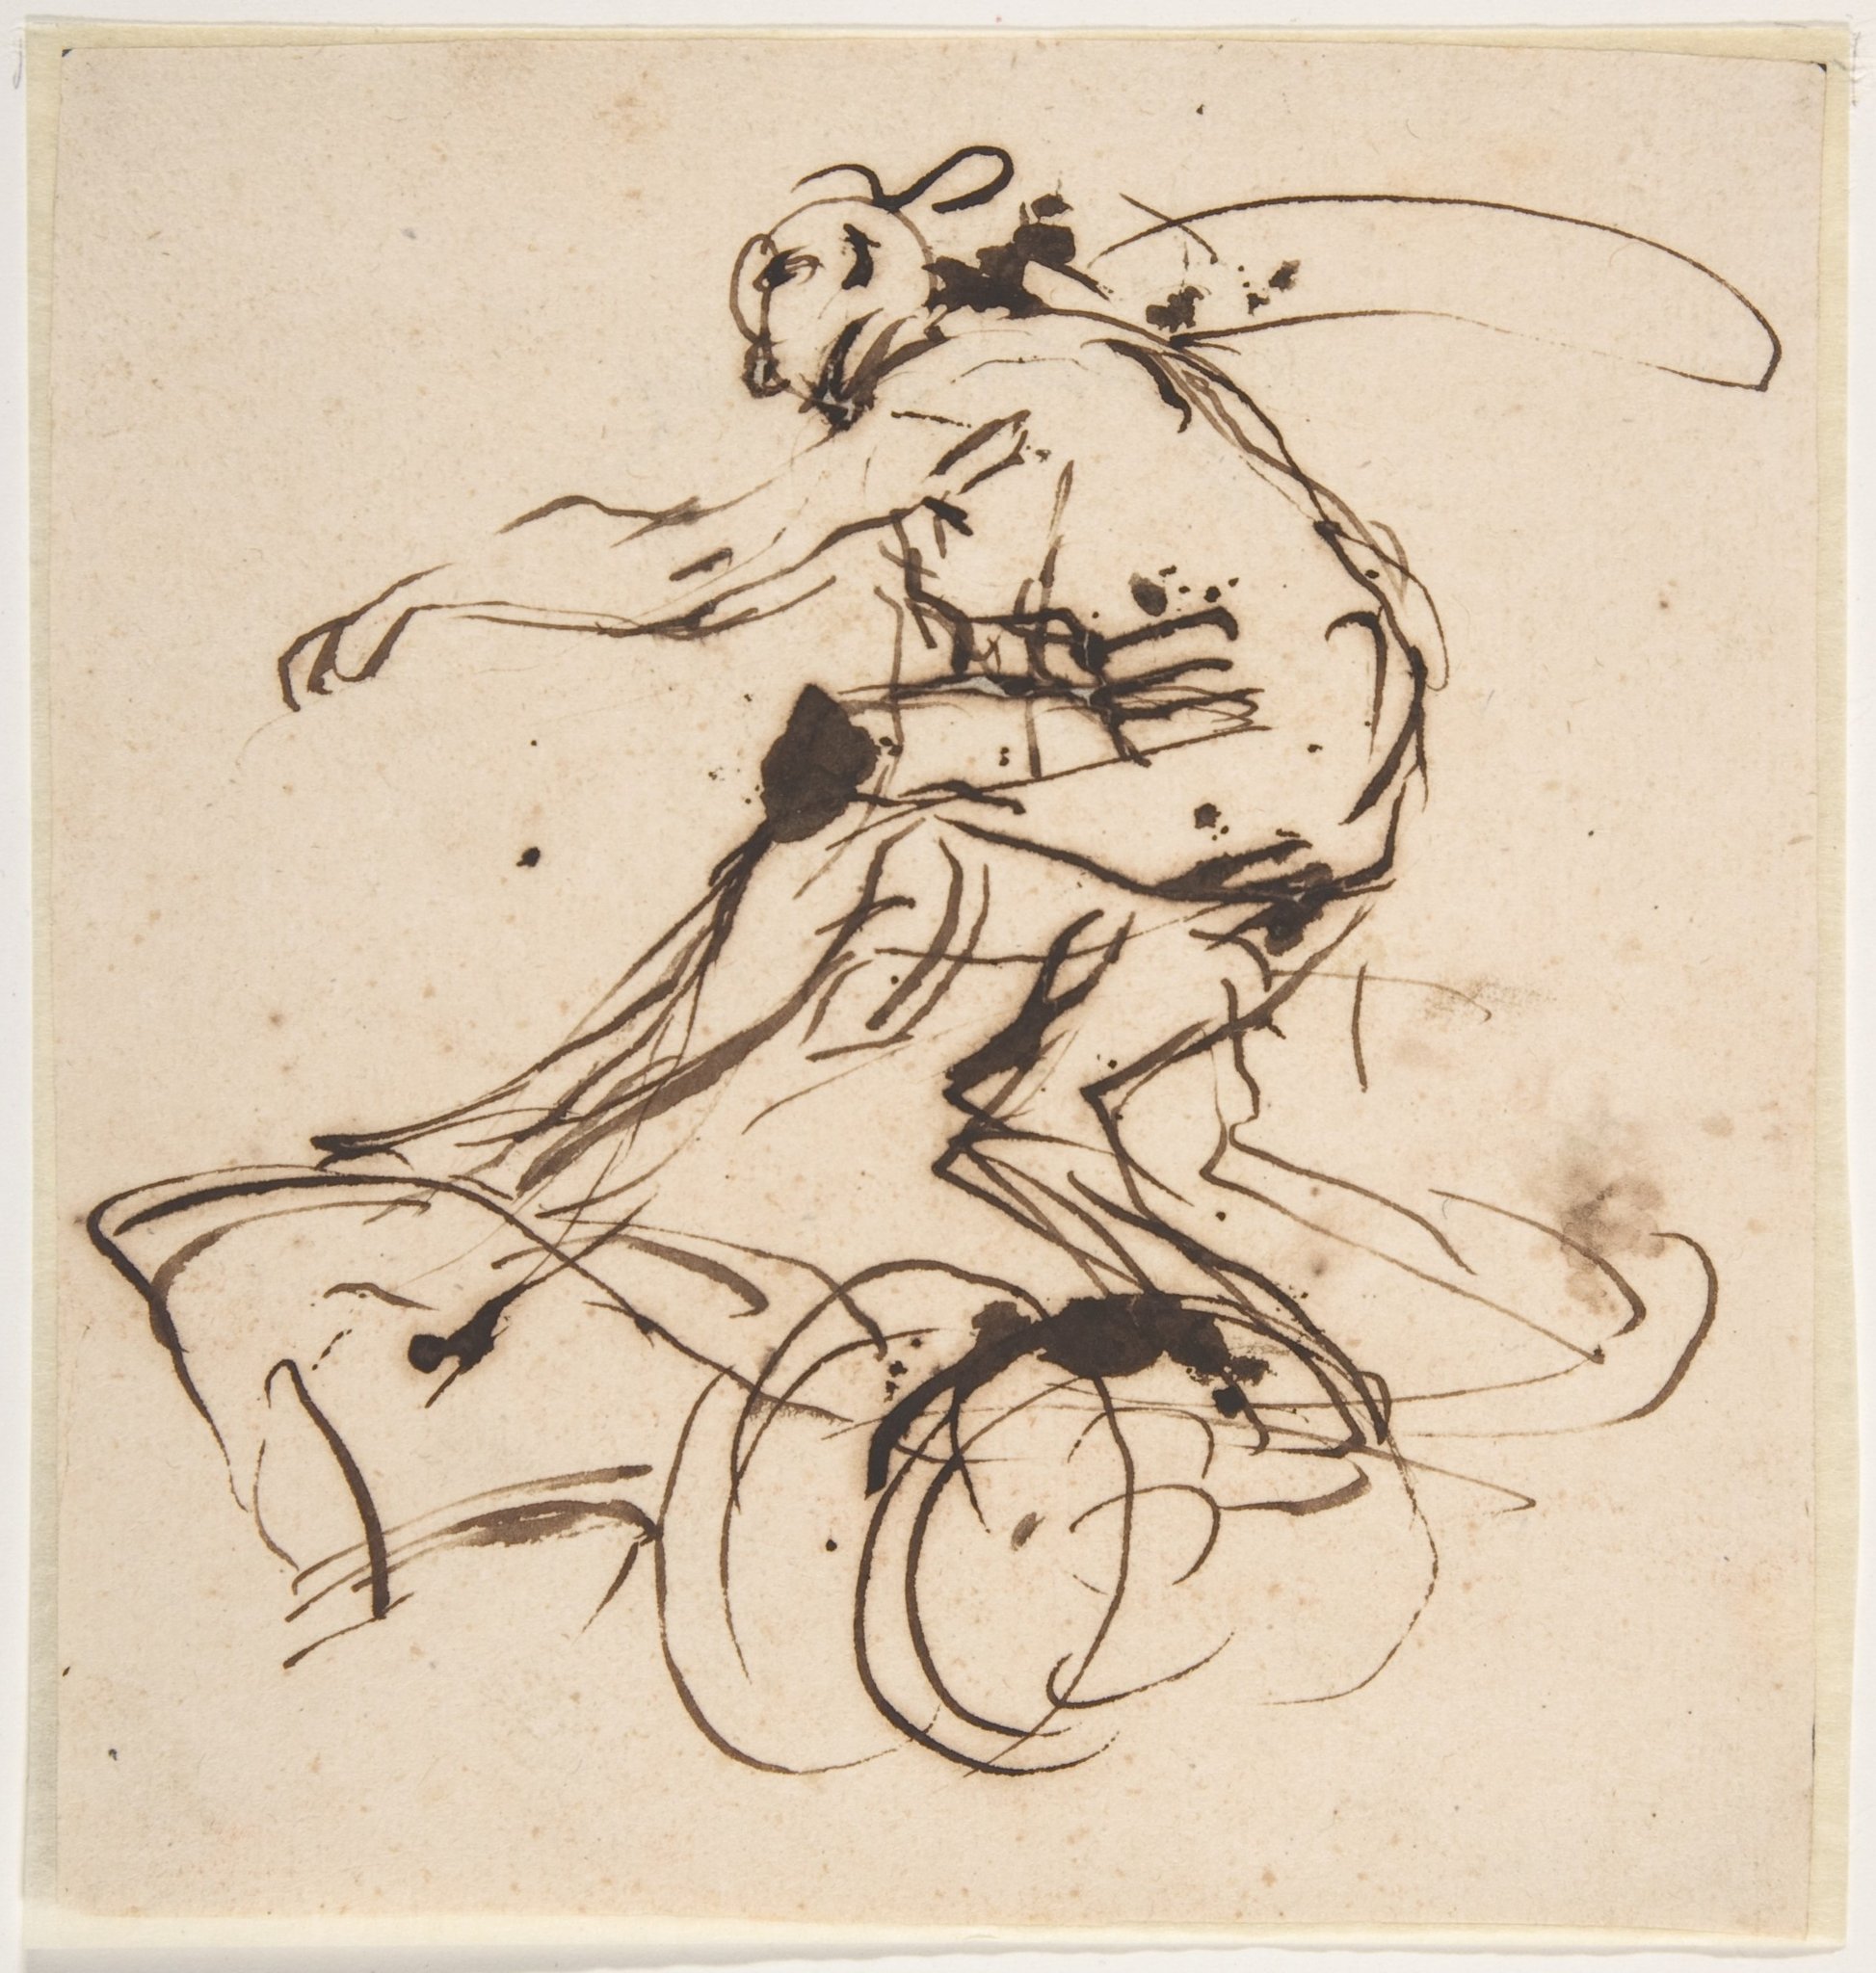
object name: drawing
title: Charioteer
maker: micco spadaro (domenico gargiulo)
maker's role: artist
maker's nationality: italian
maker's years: 1609-1675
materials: ink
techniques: pen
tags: men,chariots